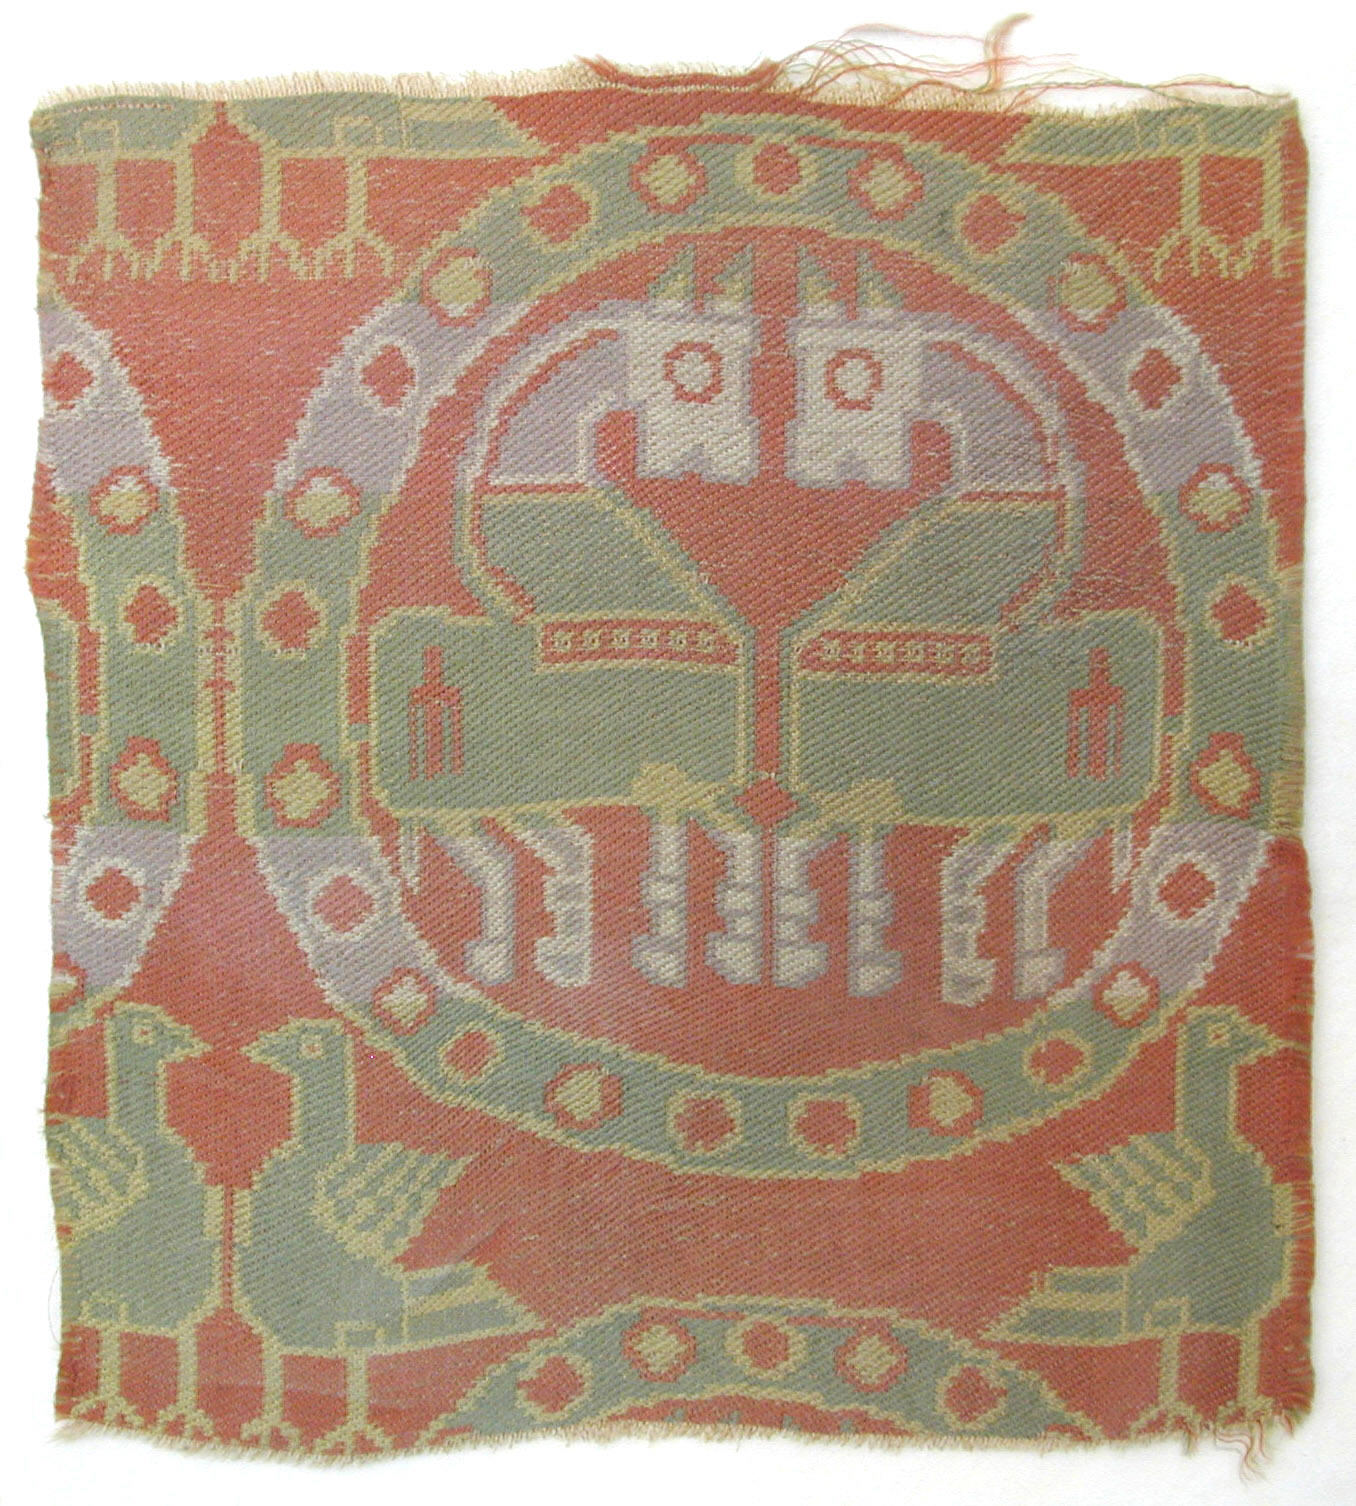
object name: textile fragment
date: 701-900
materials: silk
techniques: weave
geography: iran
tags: birds